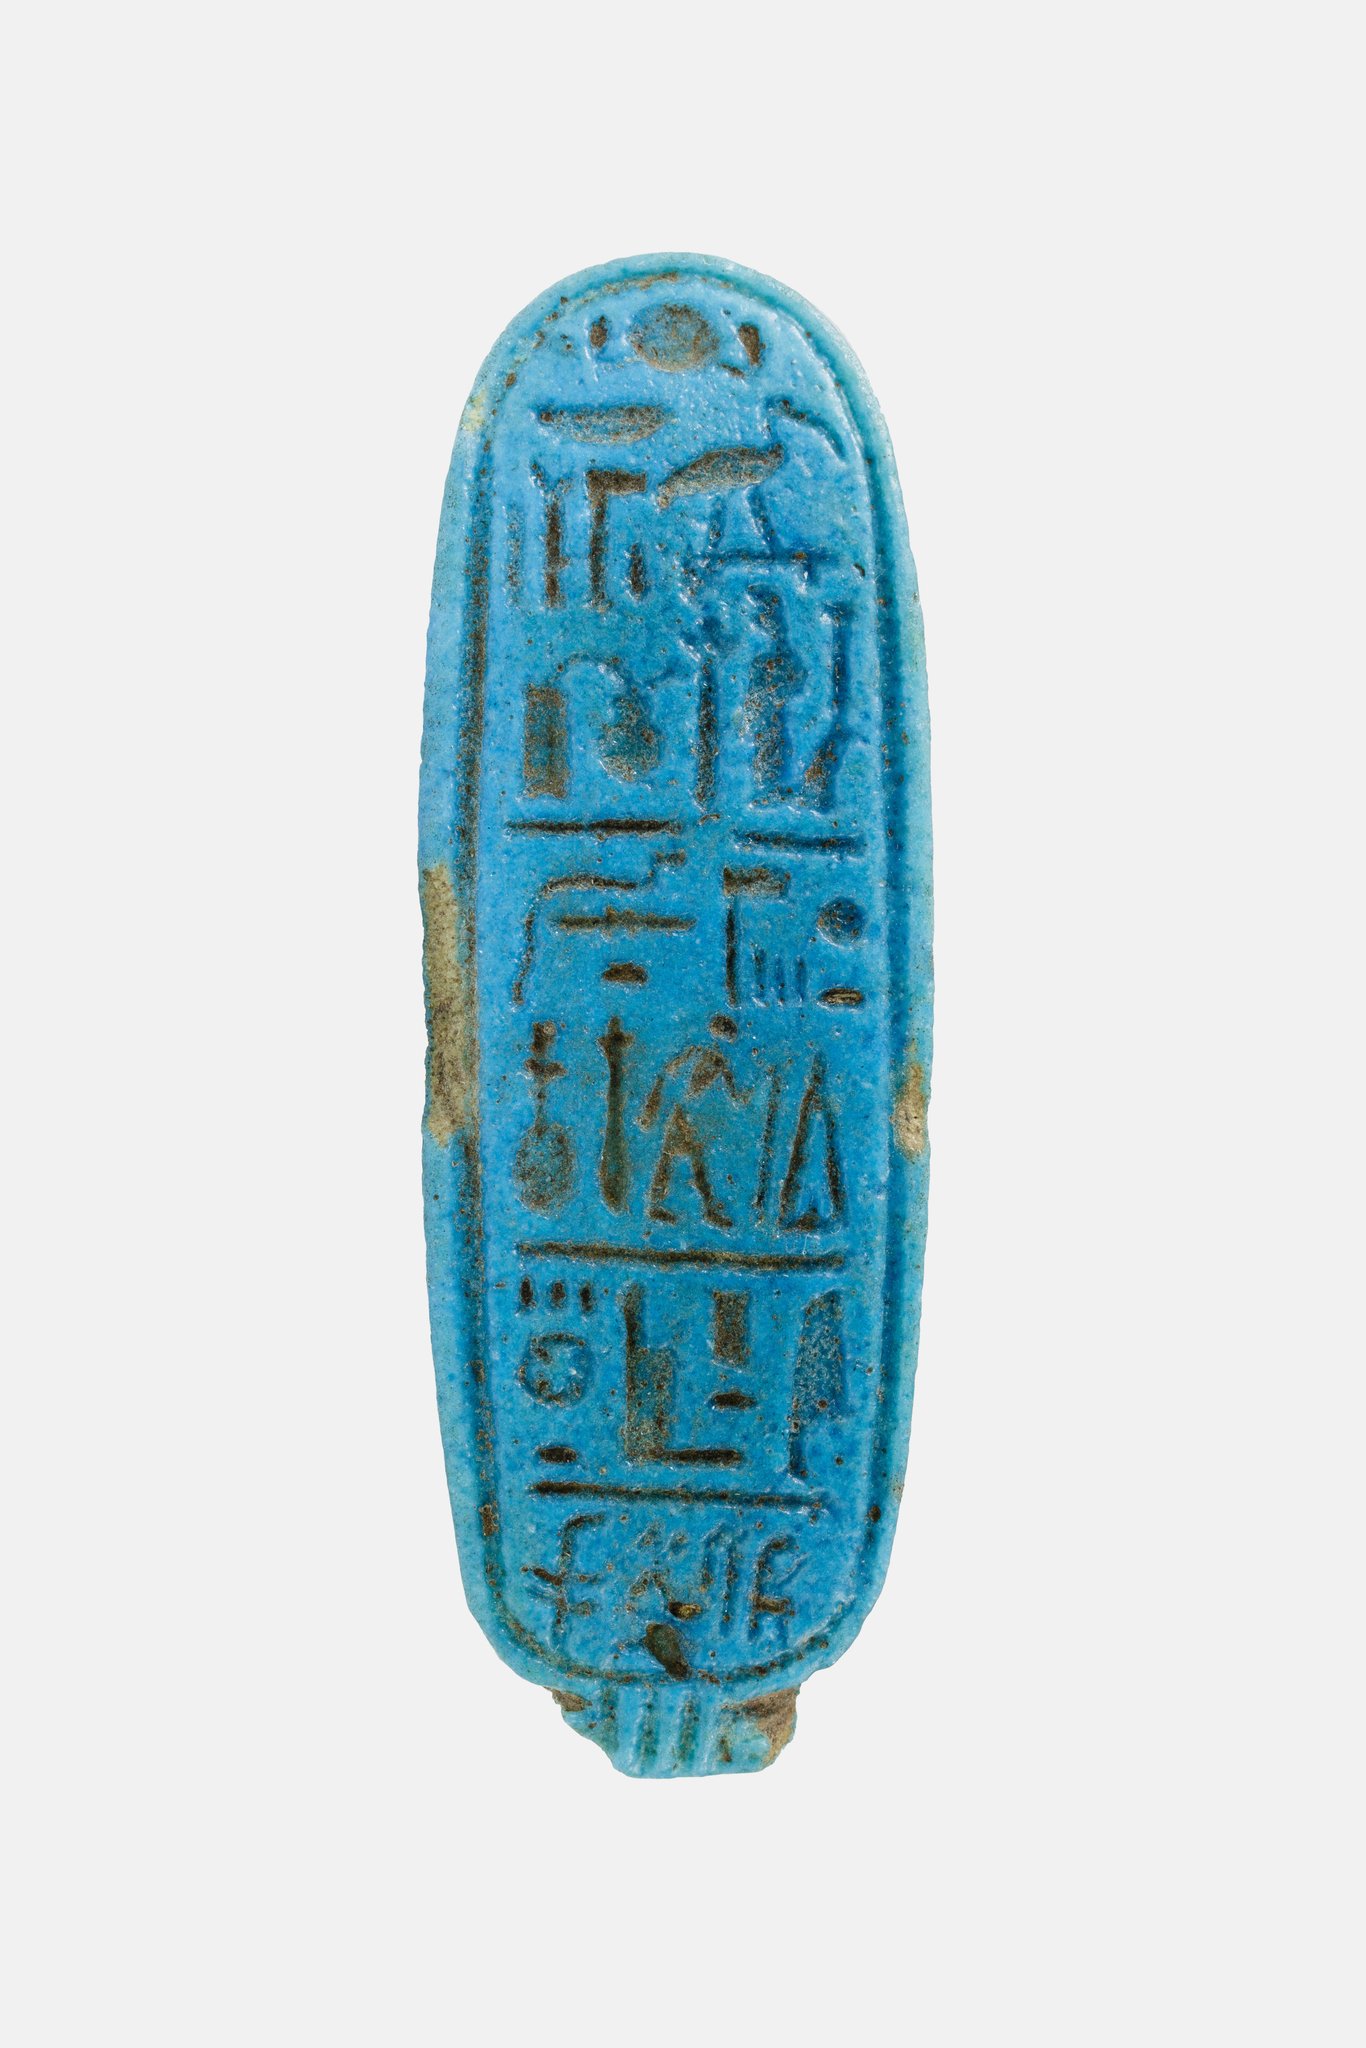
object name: ring, signet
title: Signet ring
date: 1295-1070 BCE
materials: faience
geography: egypt